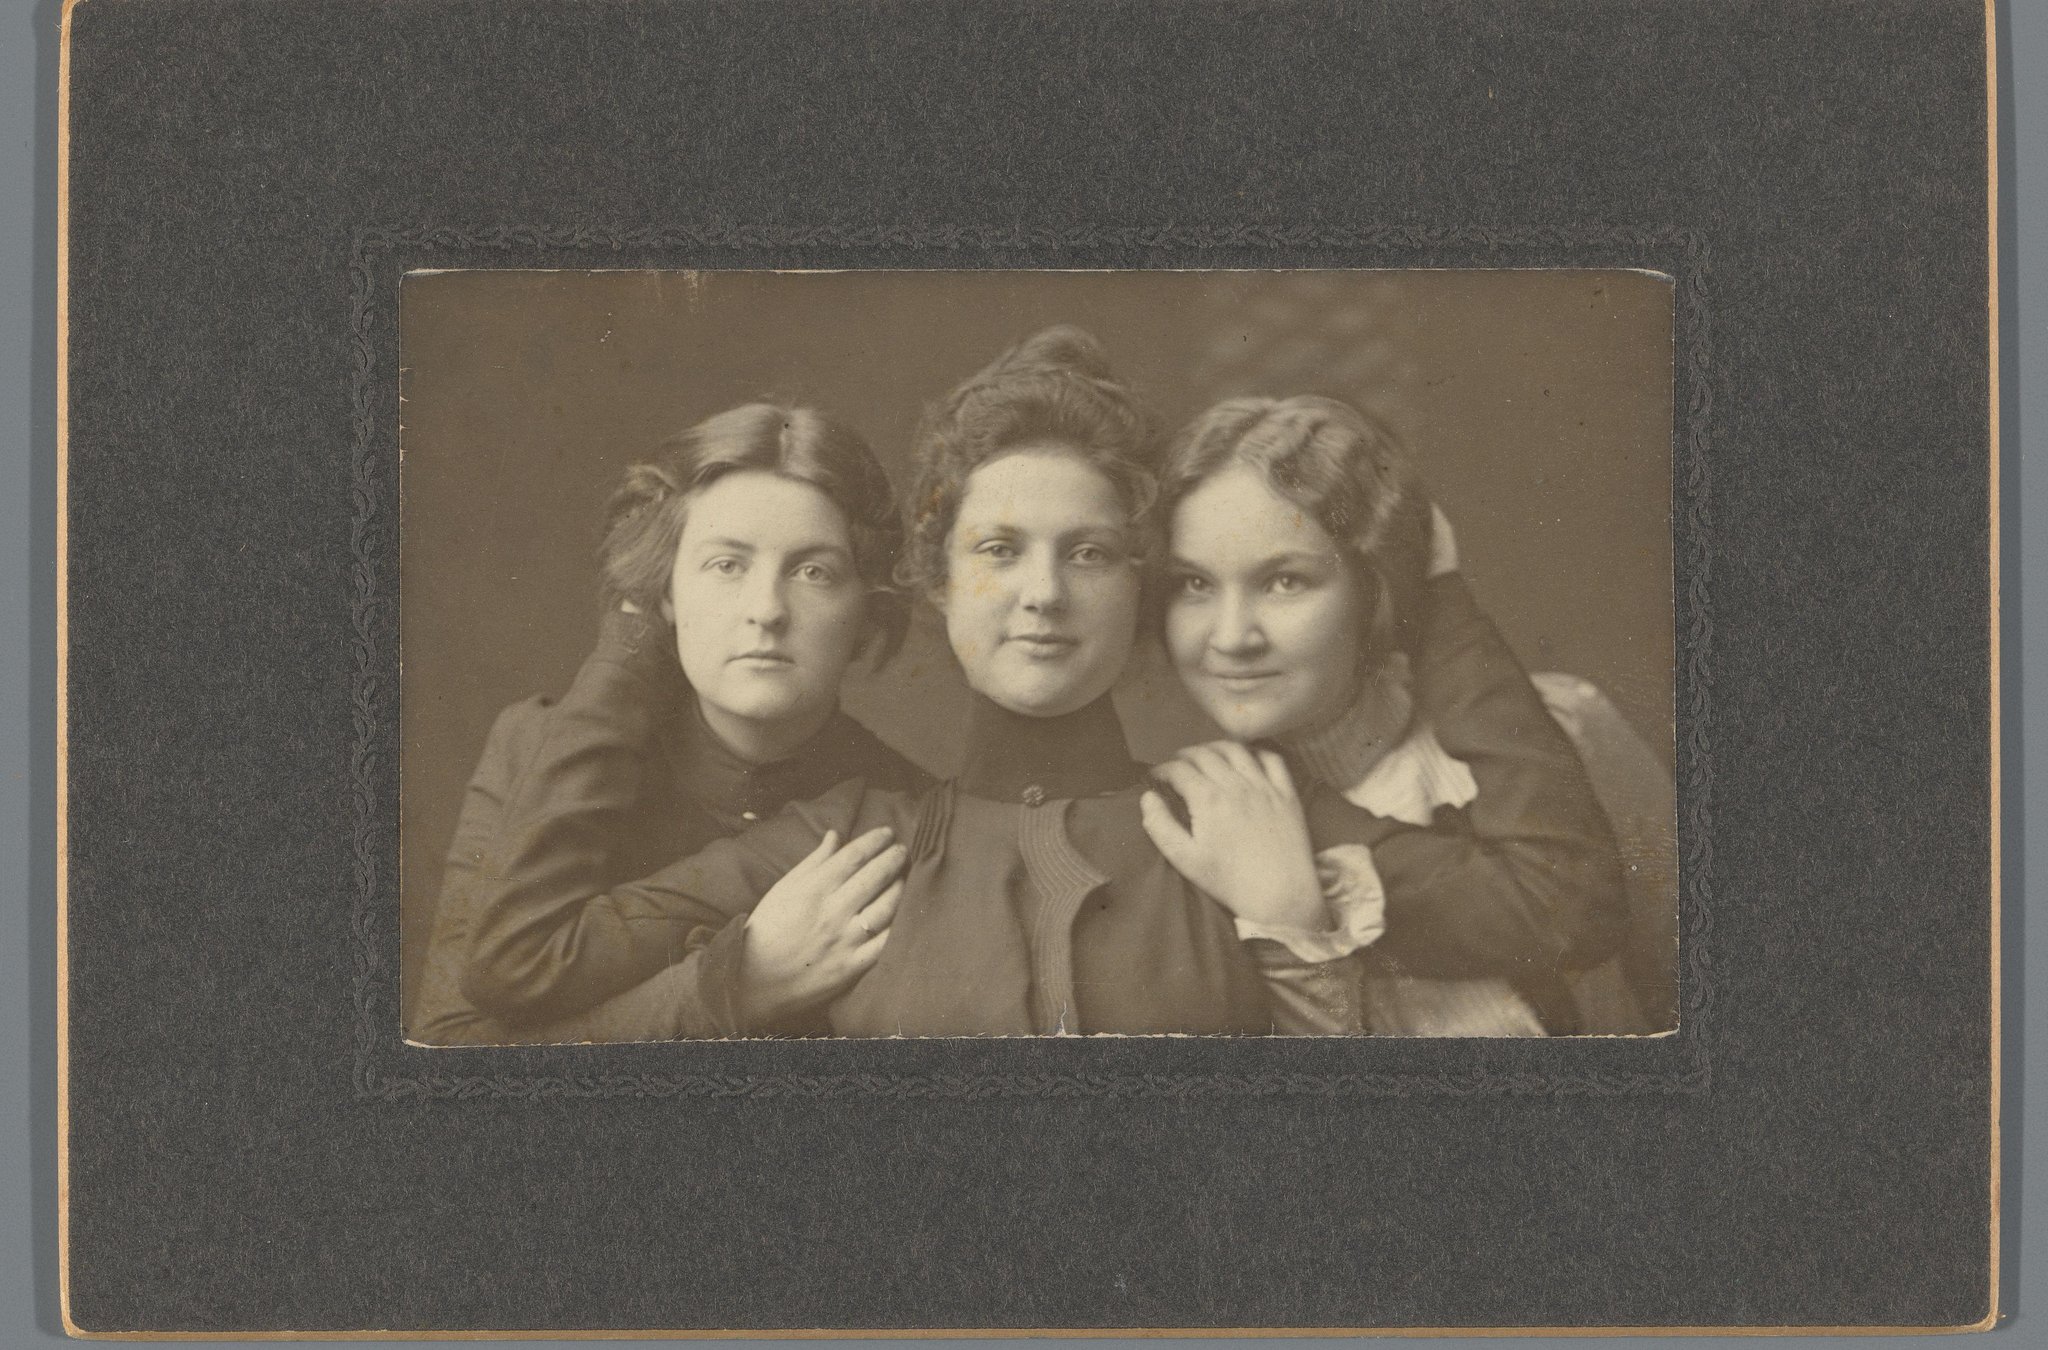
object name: photograph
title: Drie vrouwen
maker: Anonymous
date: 1900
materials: cardboard, photographic support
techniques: photography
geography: united states